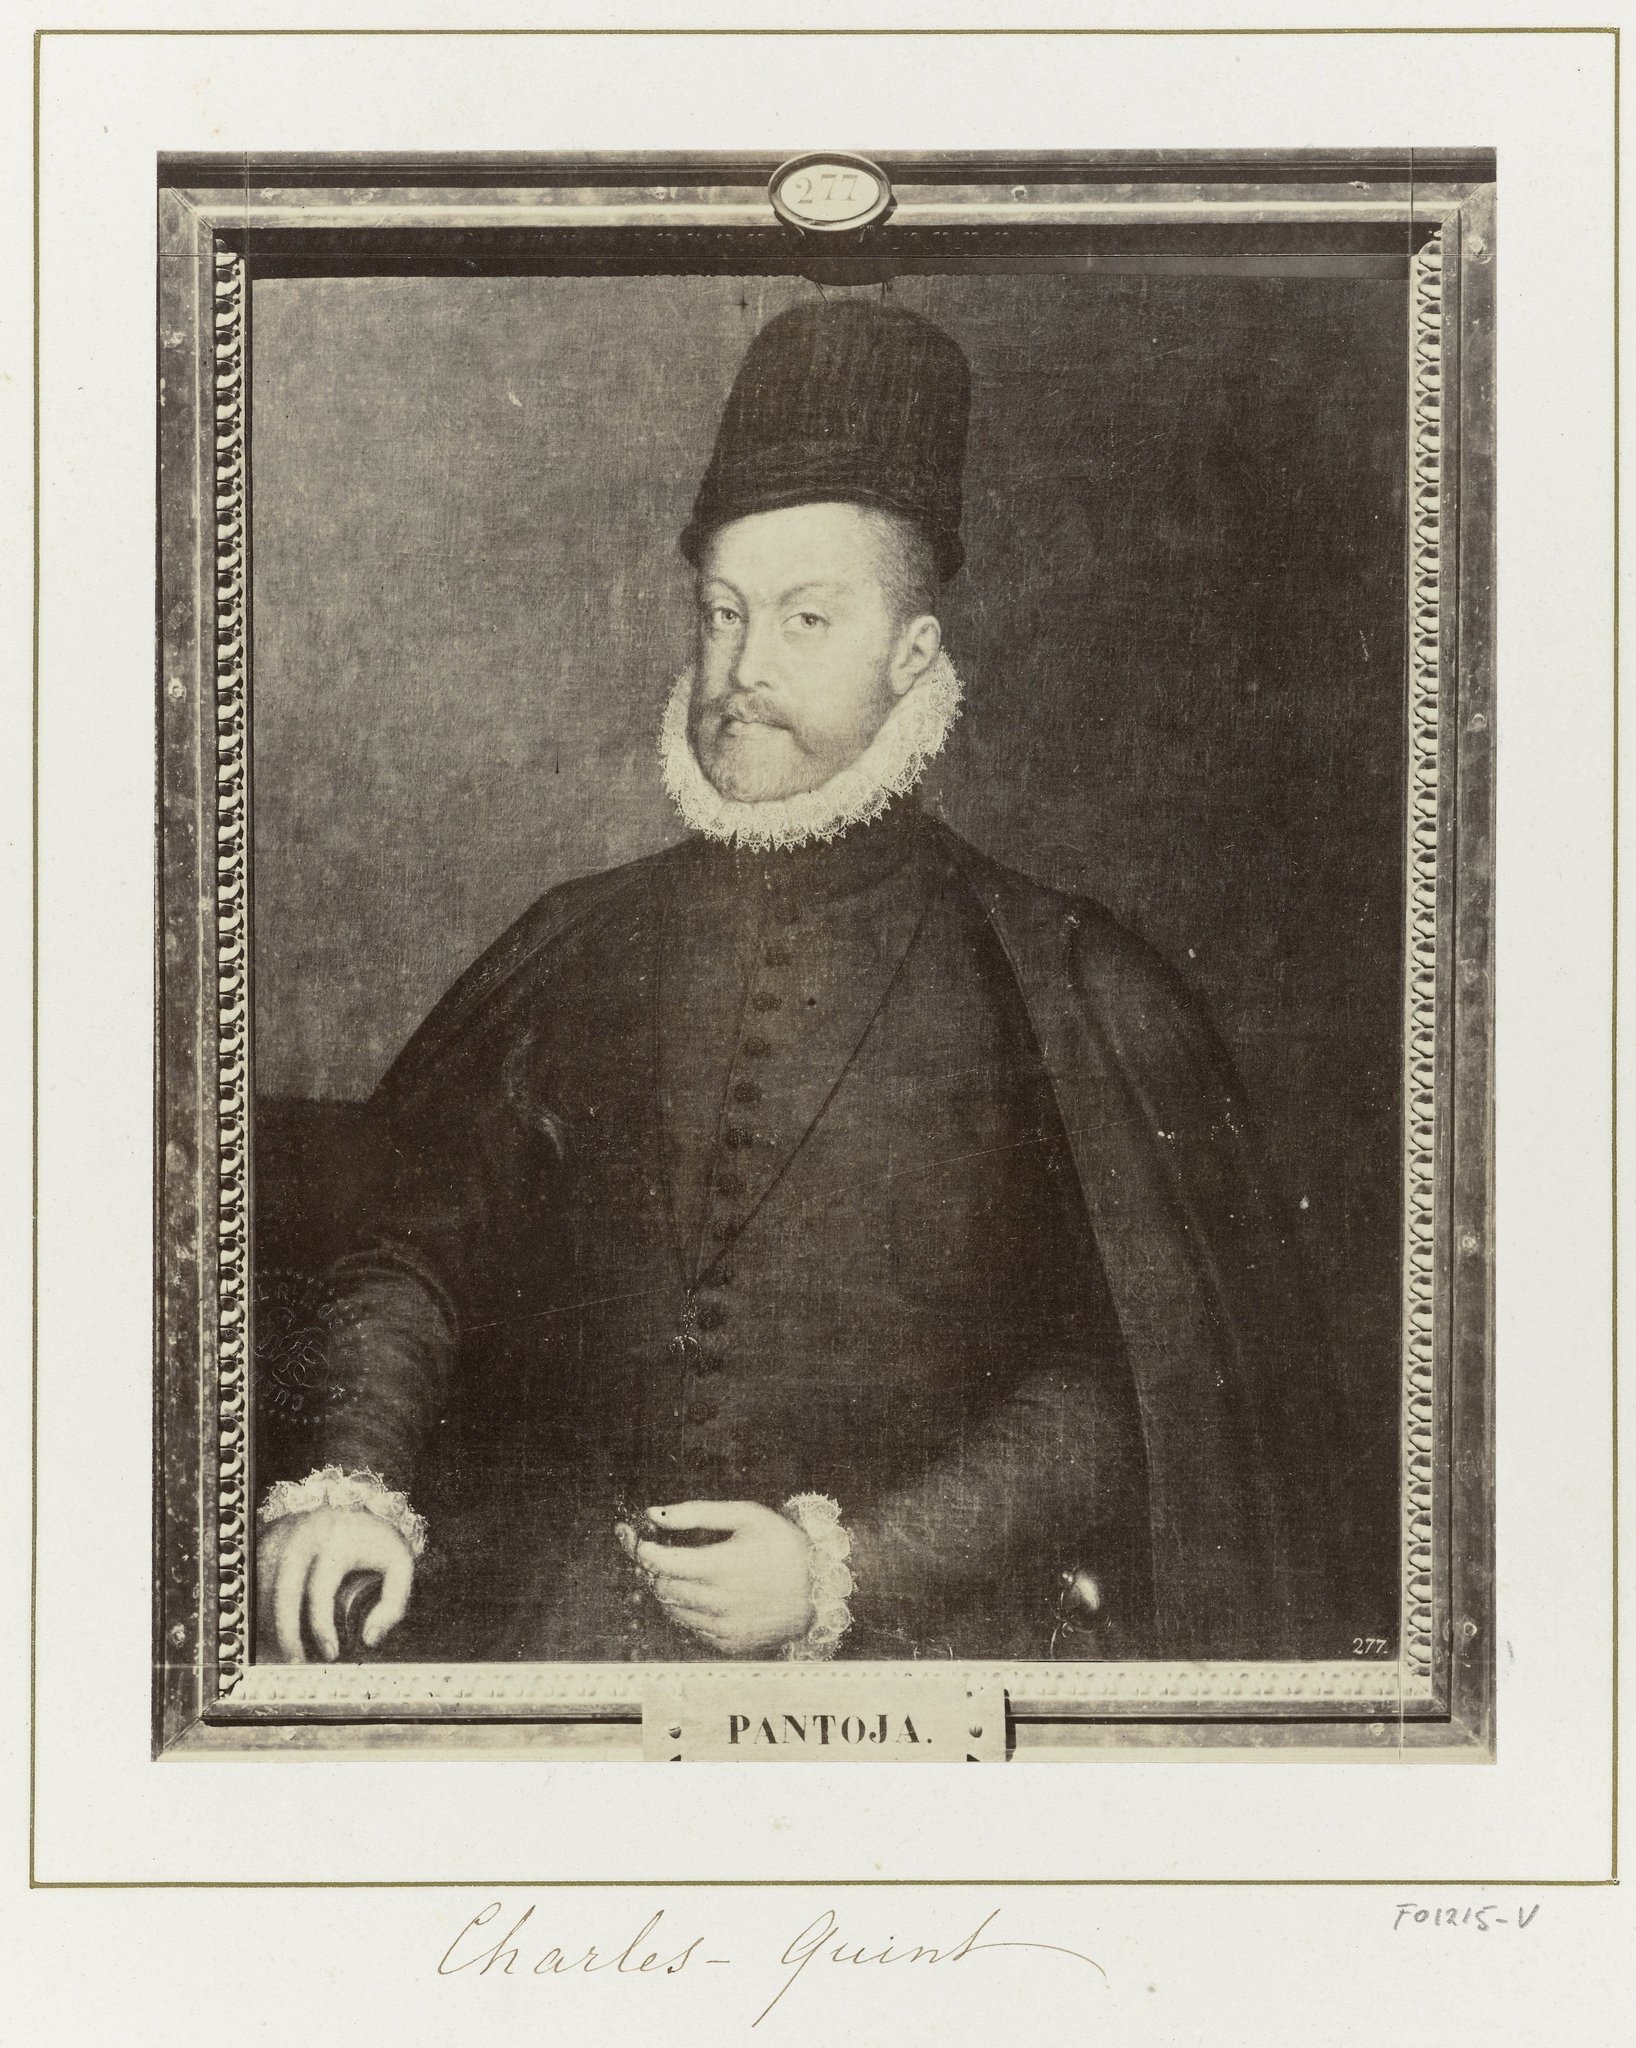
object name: reproduction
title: Fotoreproductie van een schilderij door Juan Pantoja de la Cruz, voorstellend een portret van Filips II van Spanje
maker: Anonymous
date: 1860-1875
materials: photographic support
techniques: albumen print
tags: charles v (holy roman emperor and king of spain), ruler, sovereign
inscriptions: number: ‘277’, inscription: ‘cuadros del Rl. Museo M[...]’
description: Onderdeel van Reisalbum met opnames van kunstwerken, personen en bezienswaardigheden in Spanje.